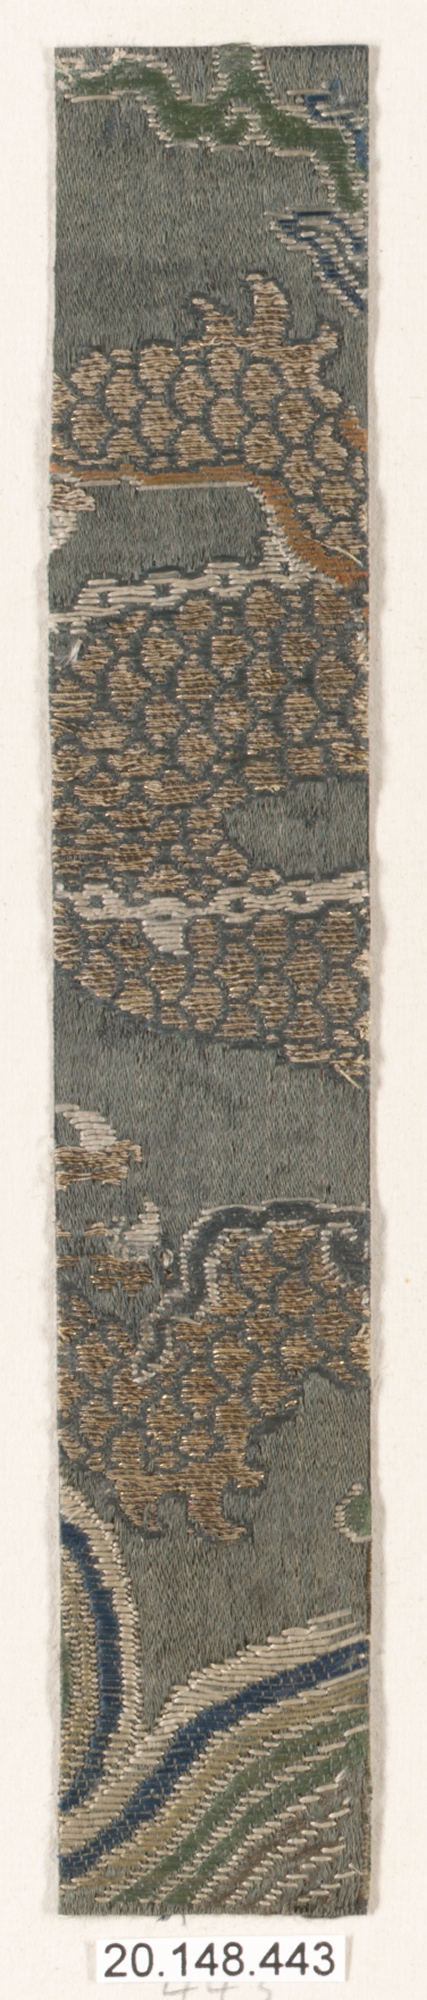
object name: piece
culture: chinese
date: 1701-1800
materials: silk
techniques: compound weave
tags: dragons